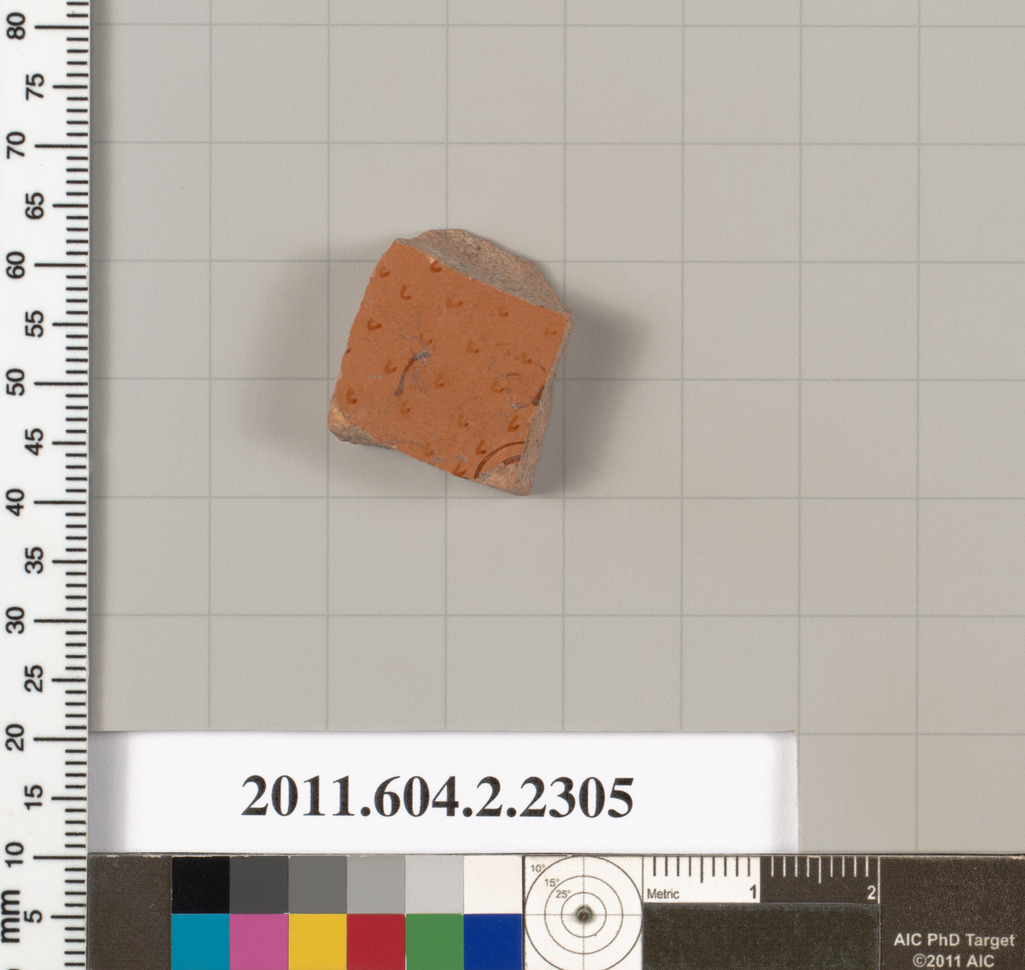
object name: krater fragment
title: Terracotta fragment of a krater (bowl for mixing wine and water)?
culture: greek, attic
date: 475-451 BCE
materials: terracotta